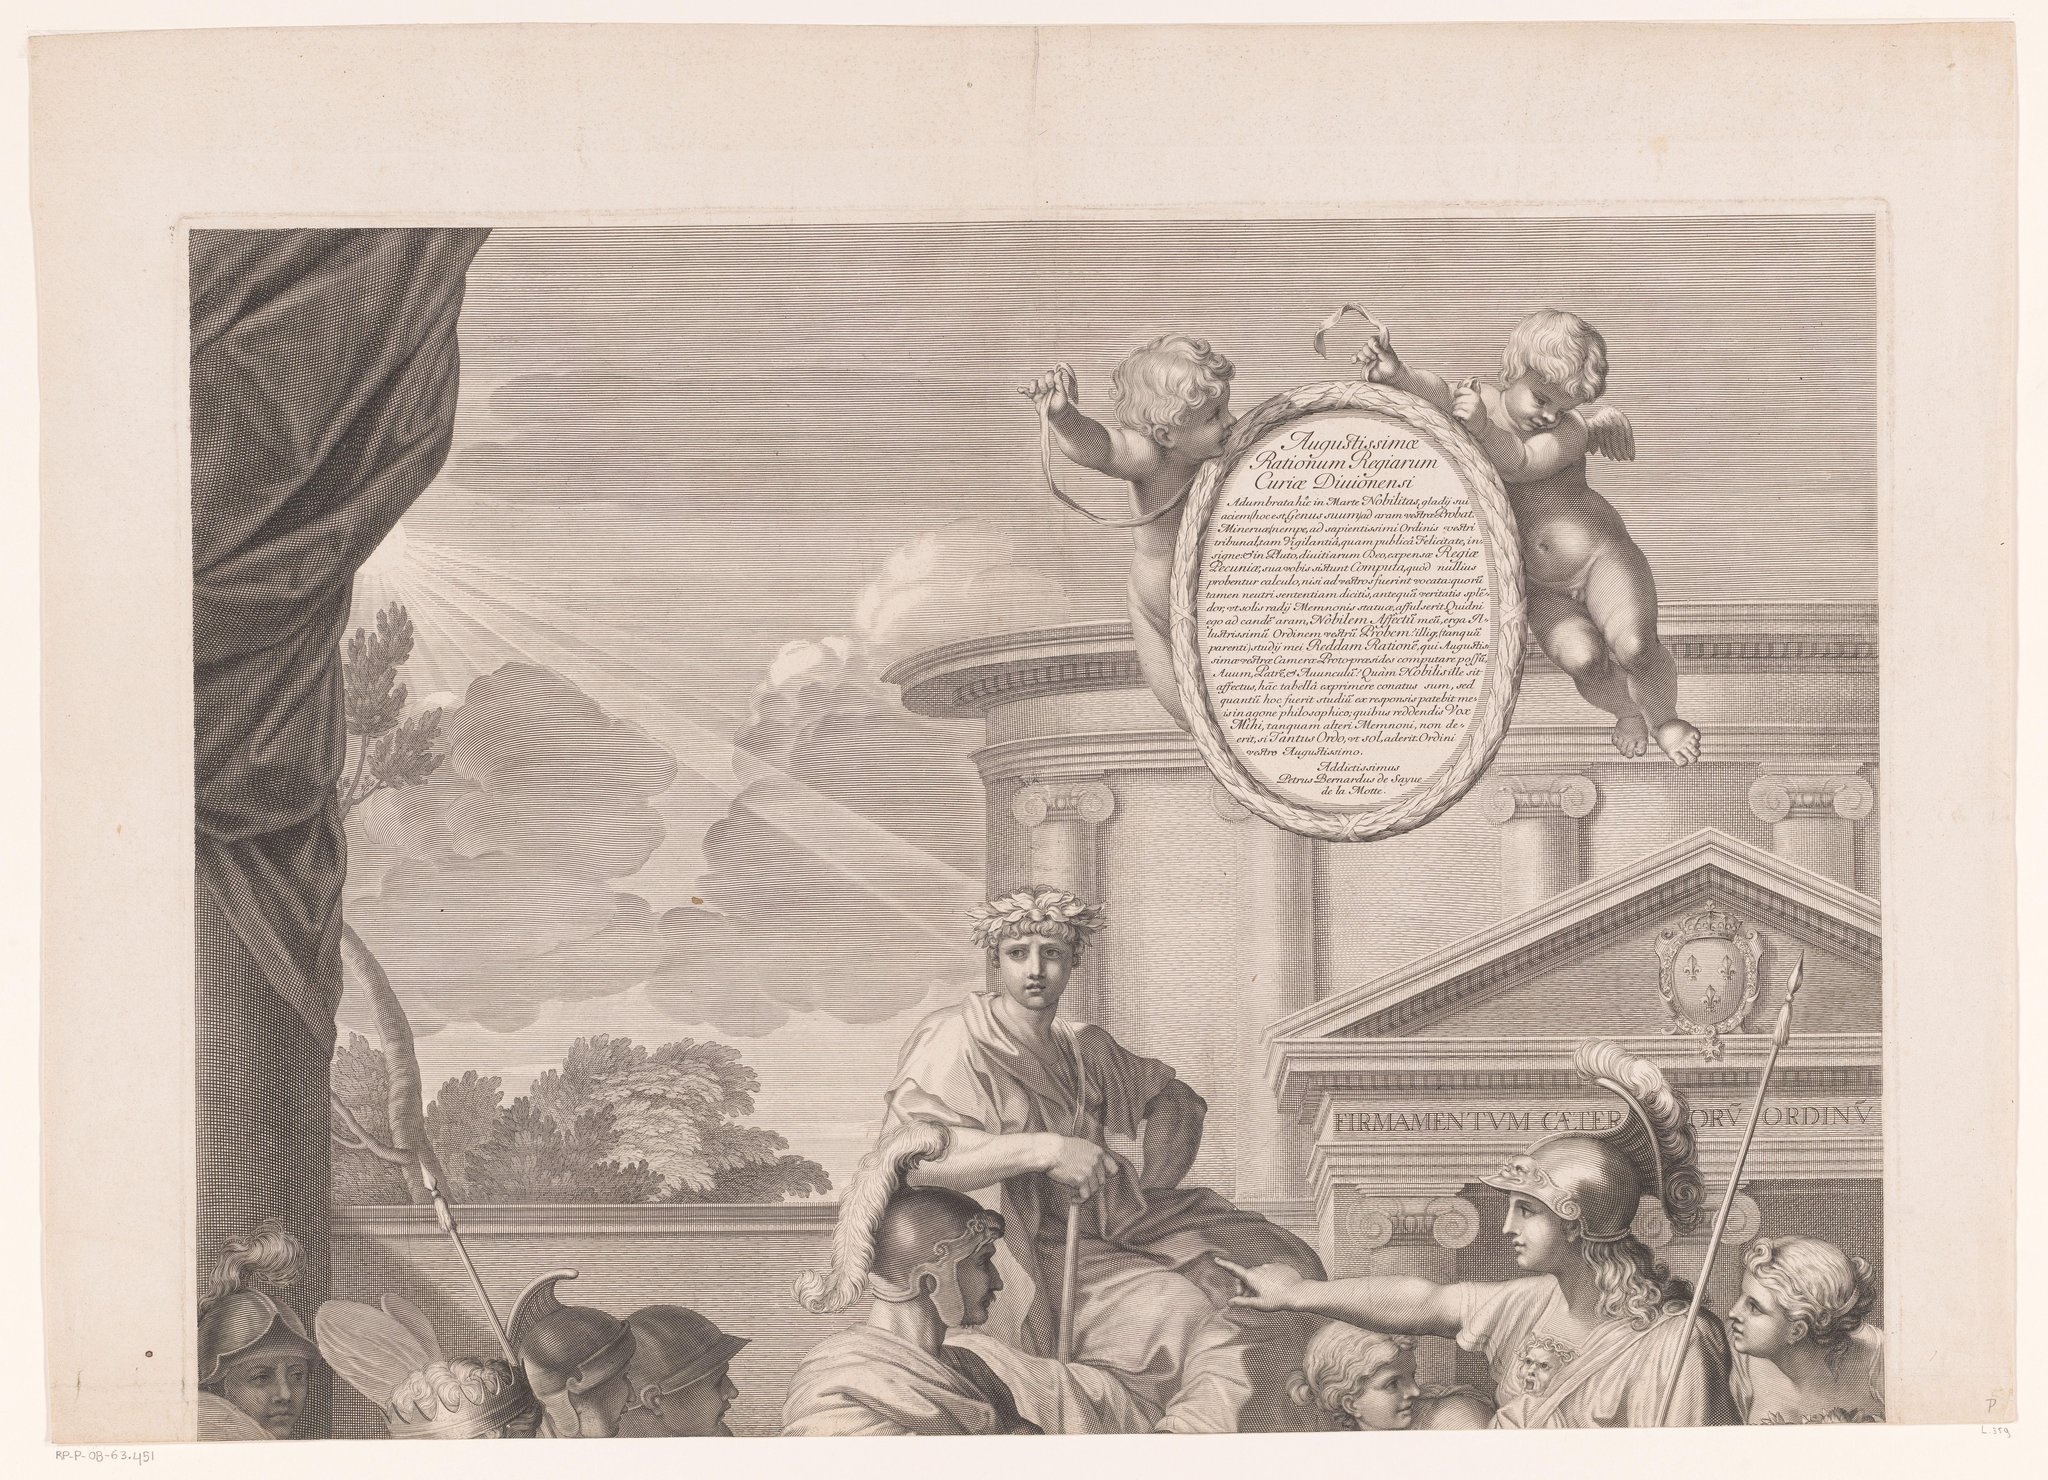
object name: print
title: Mars steekt zijn zwaard in de vlammen voor een tempel (bovenste deel)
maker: françois de poilly (i)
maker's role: print maker, publisher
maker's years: 1622-1693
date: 1656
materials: paper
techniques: engraving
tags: (story of) mars (ares), (story of) minerva (pallas, athena), plutus (god of wealth), son of ceres and iasion, (story of) memnon, son of aurora, philosophy, prudentia (prudence) as roman personification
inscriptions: collector's mark: Lugt 240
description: These van Pierre Bernard de Sayve de la Motte.